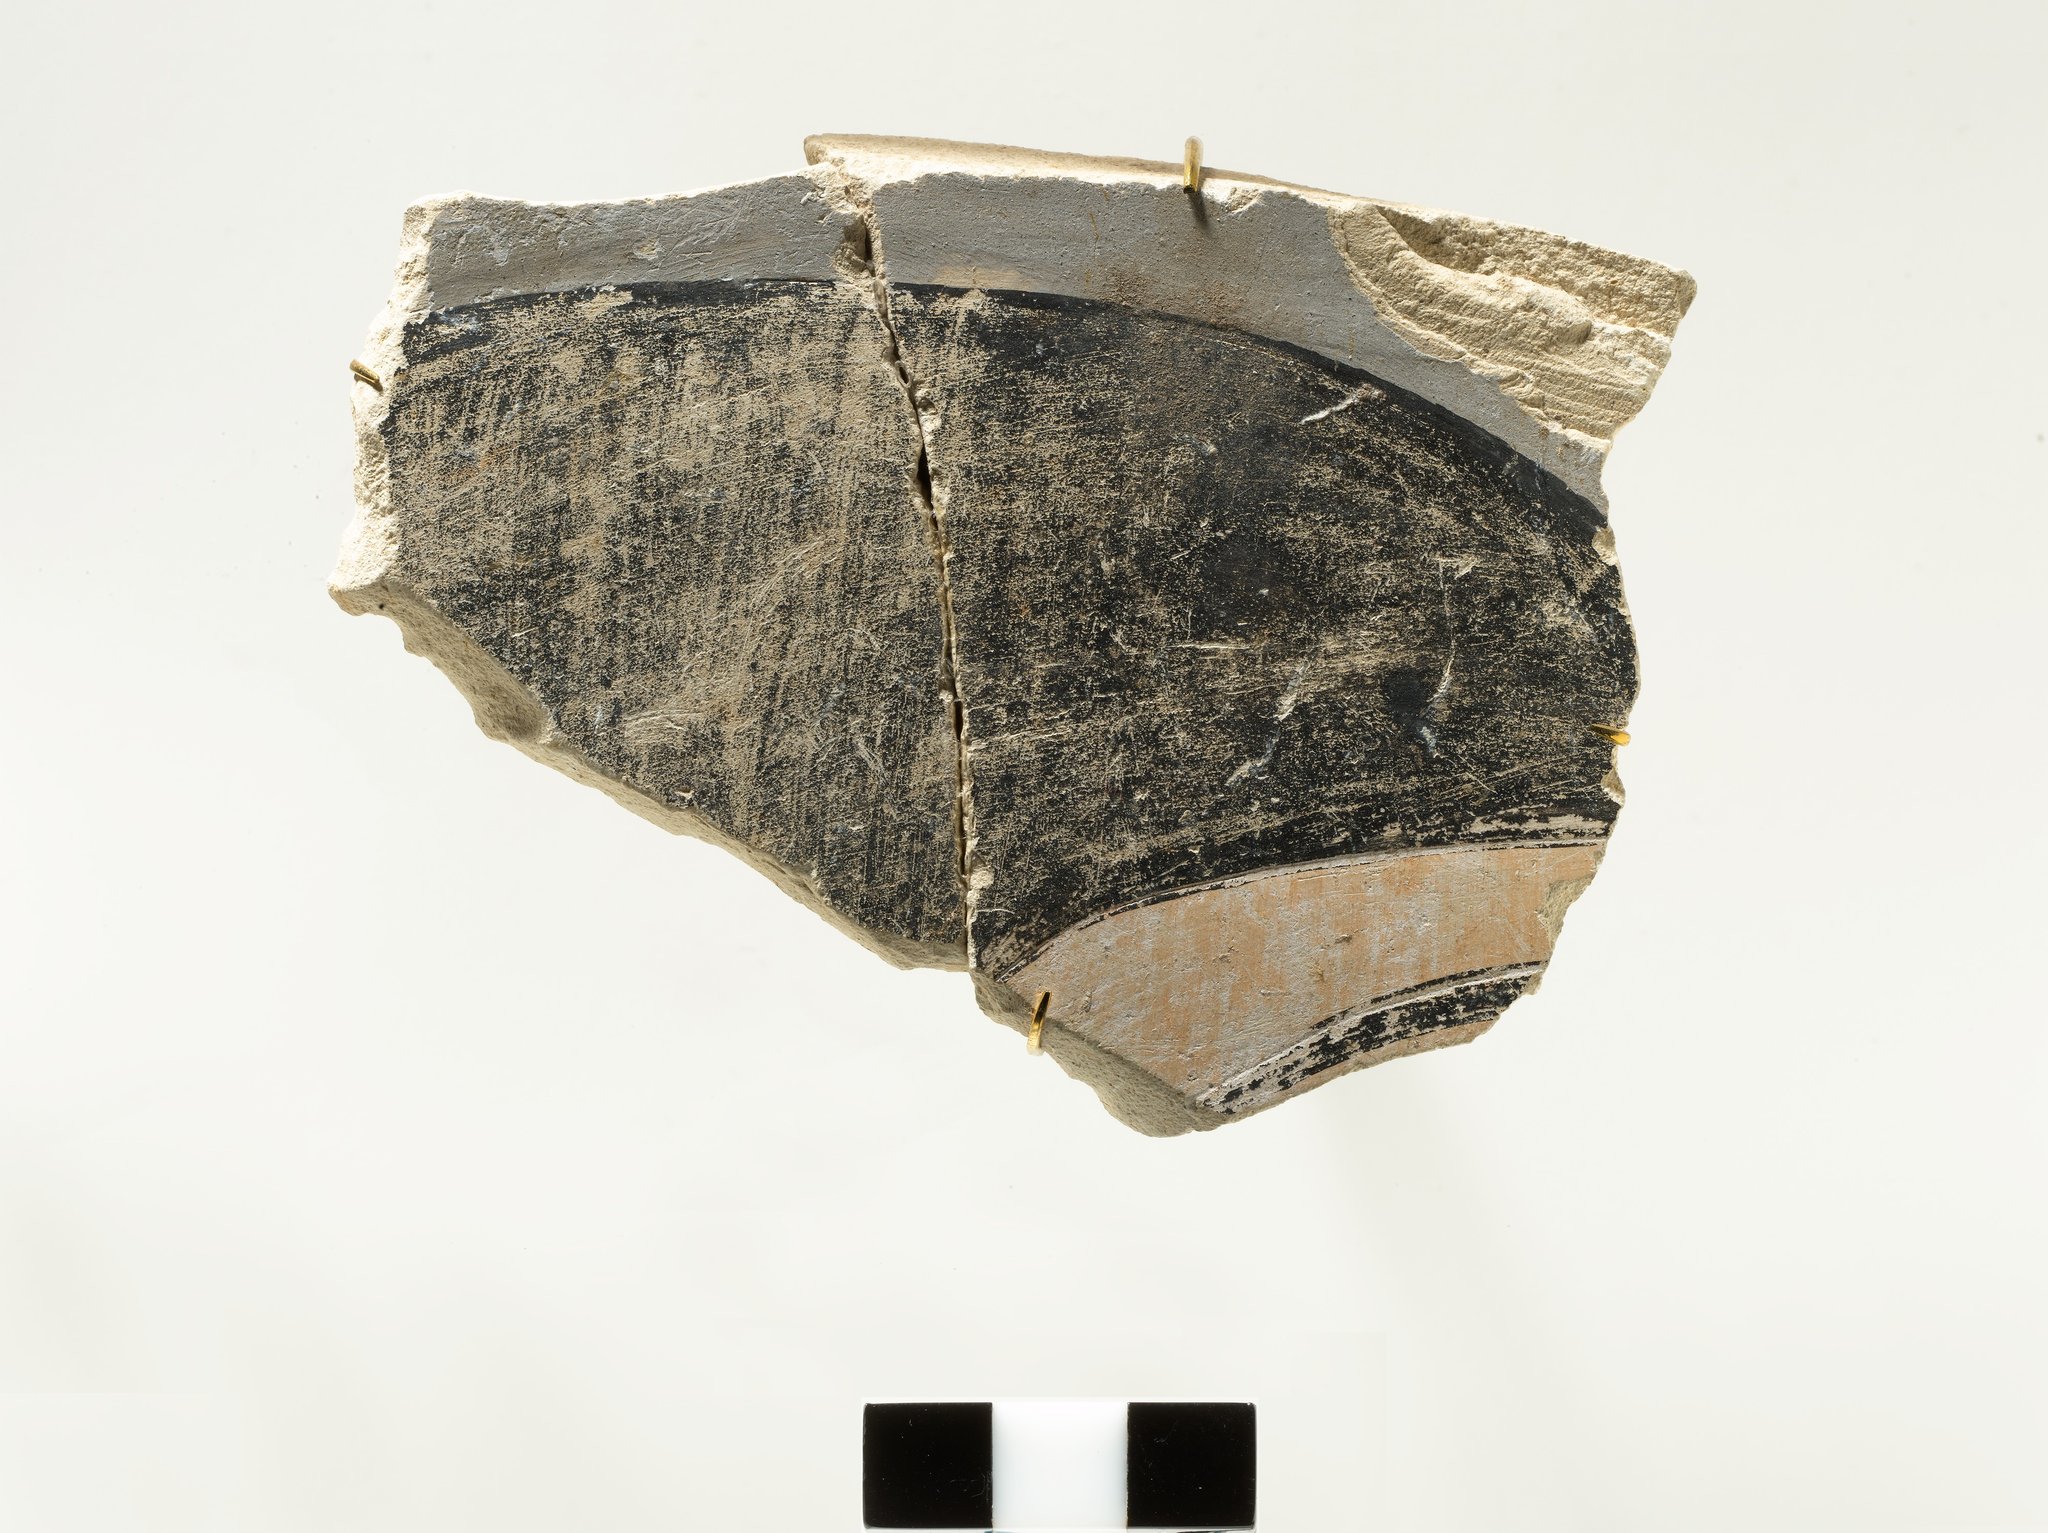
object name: relief fragment, tomb of meketre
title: Reliefs from the tomb of Meketre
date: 1981-1975 BCE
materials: limestone, paint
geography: egypt